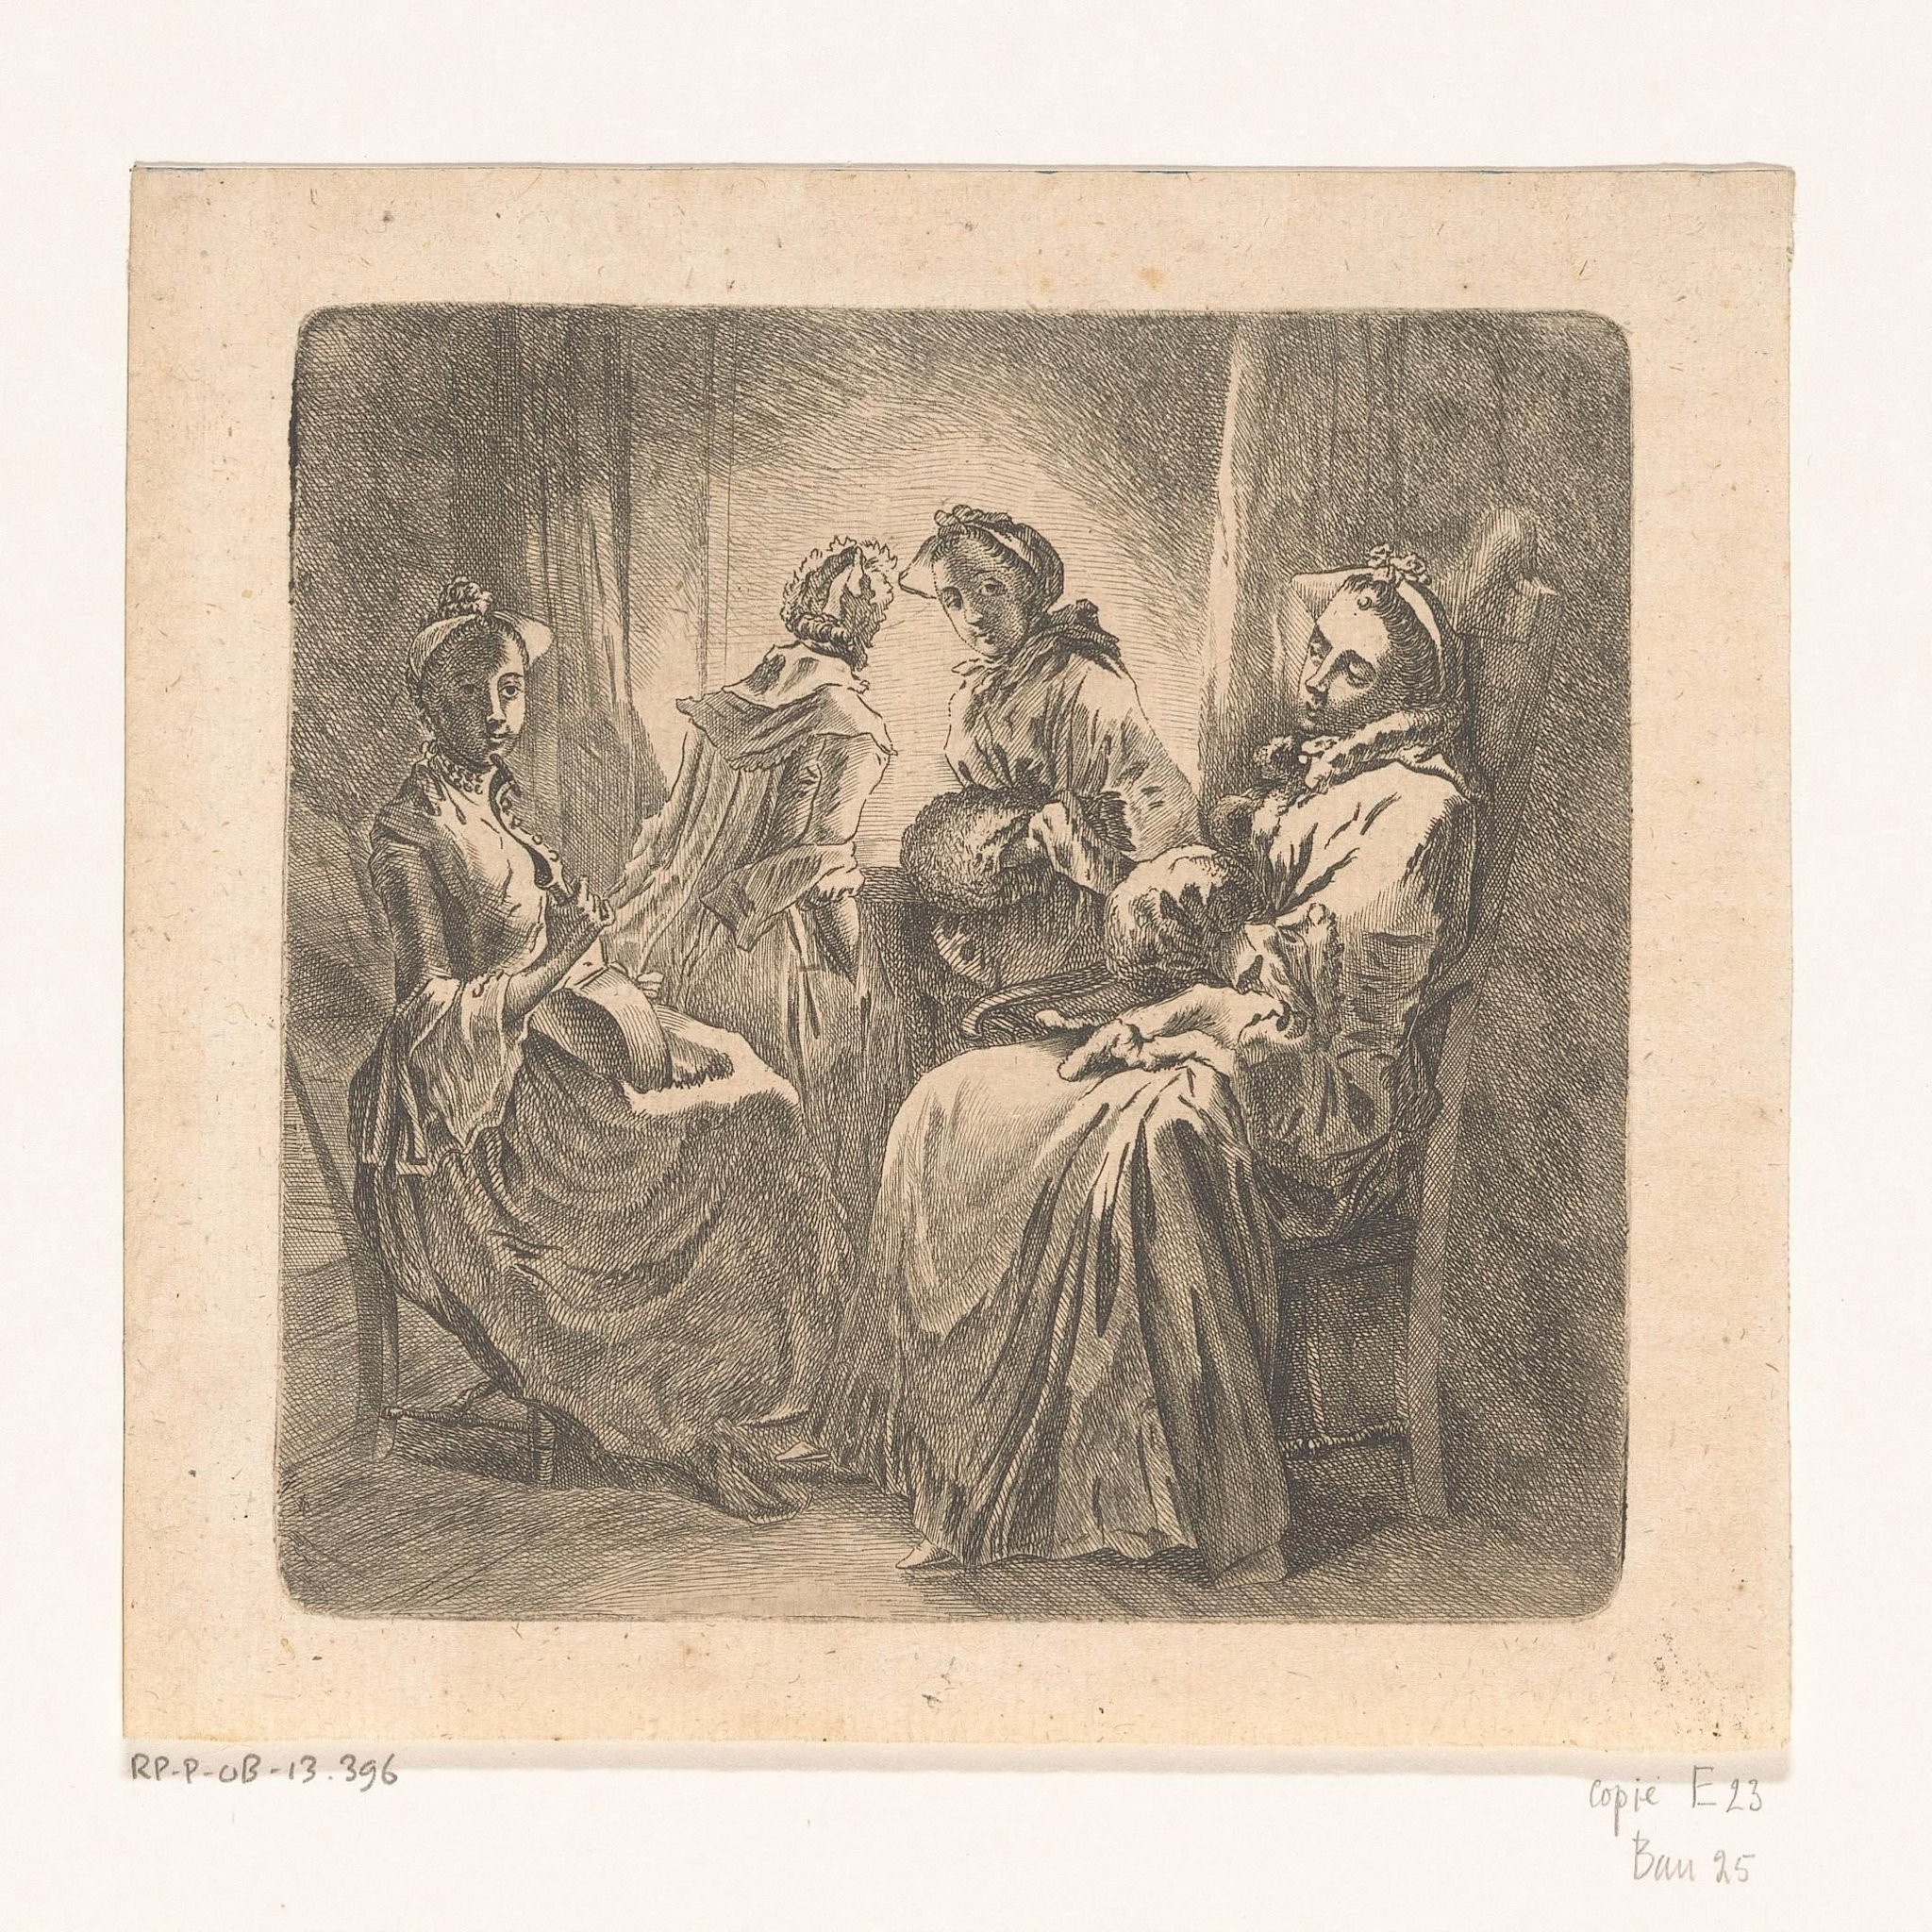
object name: print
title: Vier dames bij het venster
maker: Anonymous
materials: paper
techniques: etching, intaglio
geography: germany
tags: muff, string instruments (plucked)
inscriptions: inscription: ‘f 8,45’, collector's mark: Lugt 2228